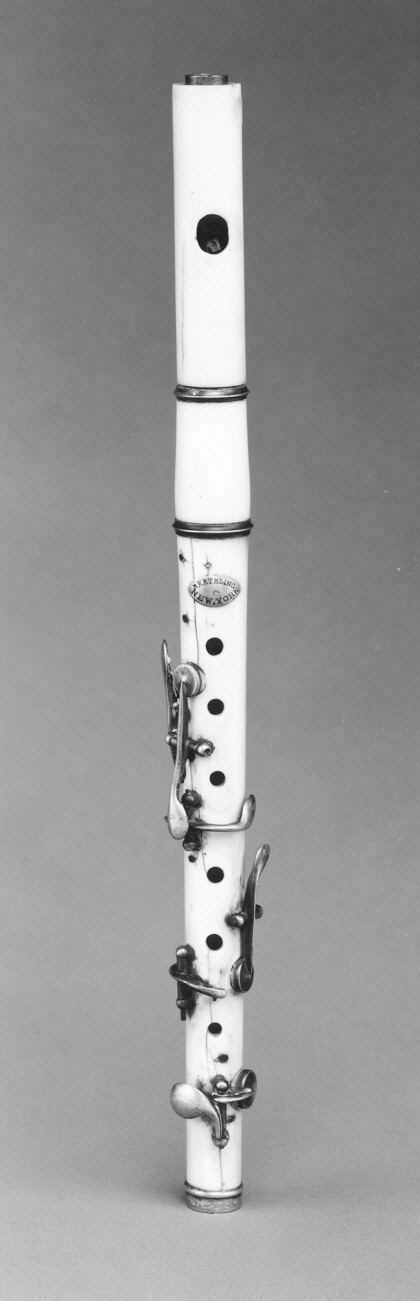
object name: piccolo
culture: american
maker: theodore berteling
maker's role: maker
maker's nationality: american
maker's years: 1821-1890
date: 1860-1875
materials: brass, ivory, silver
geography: united states